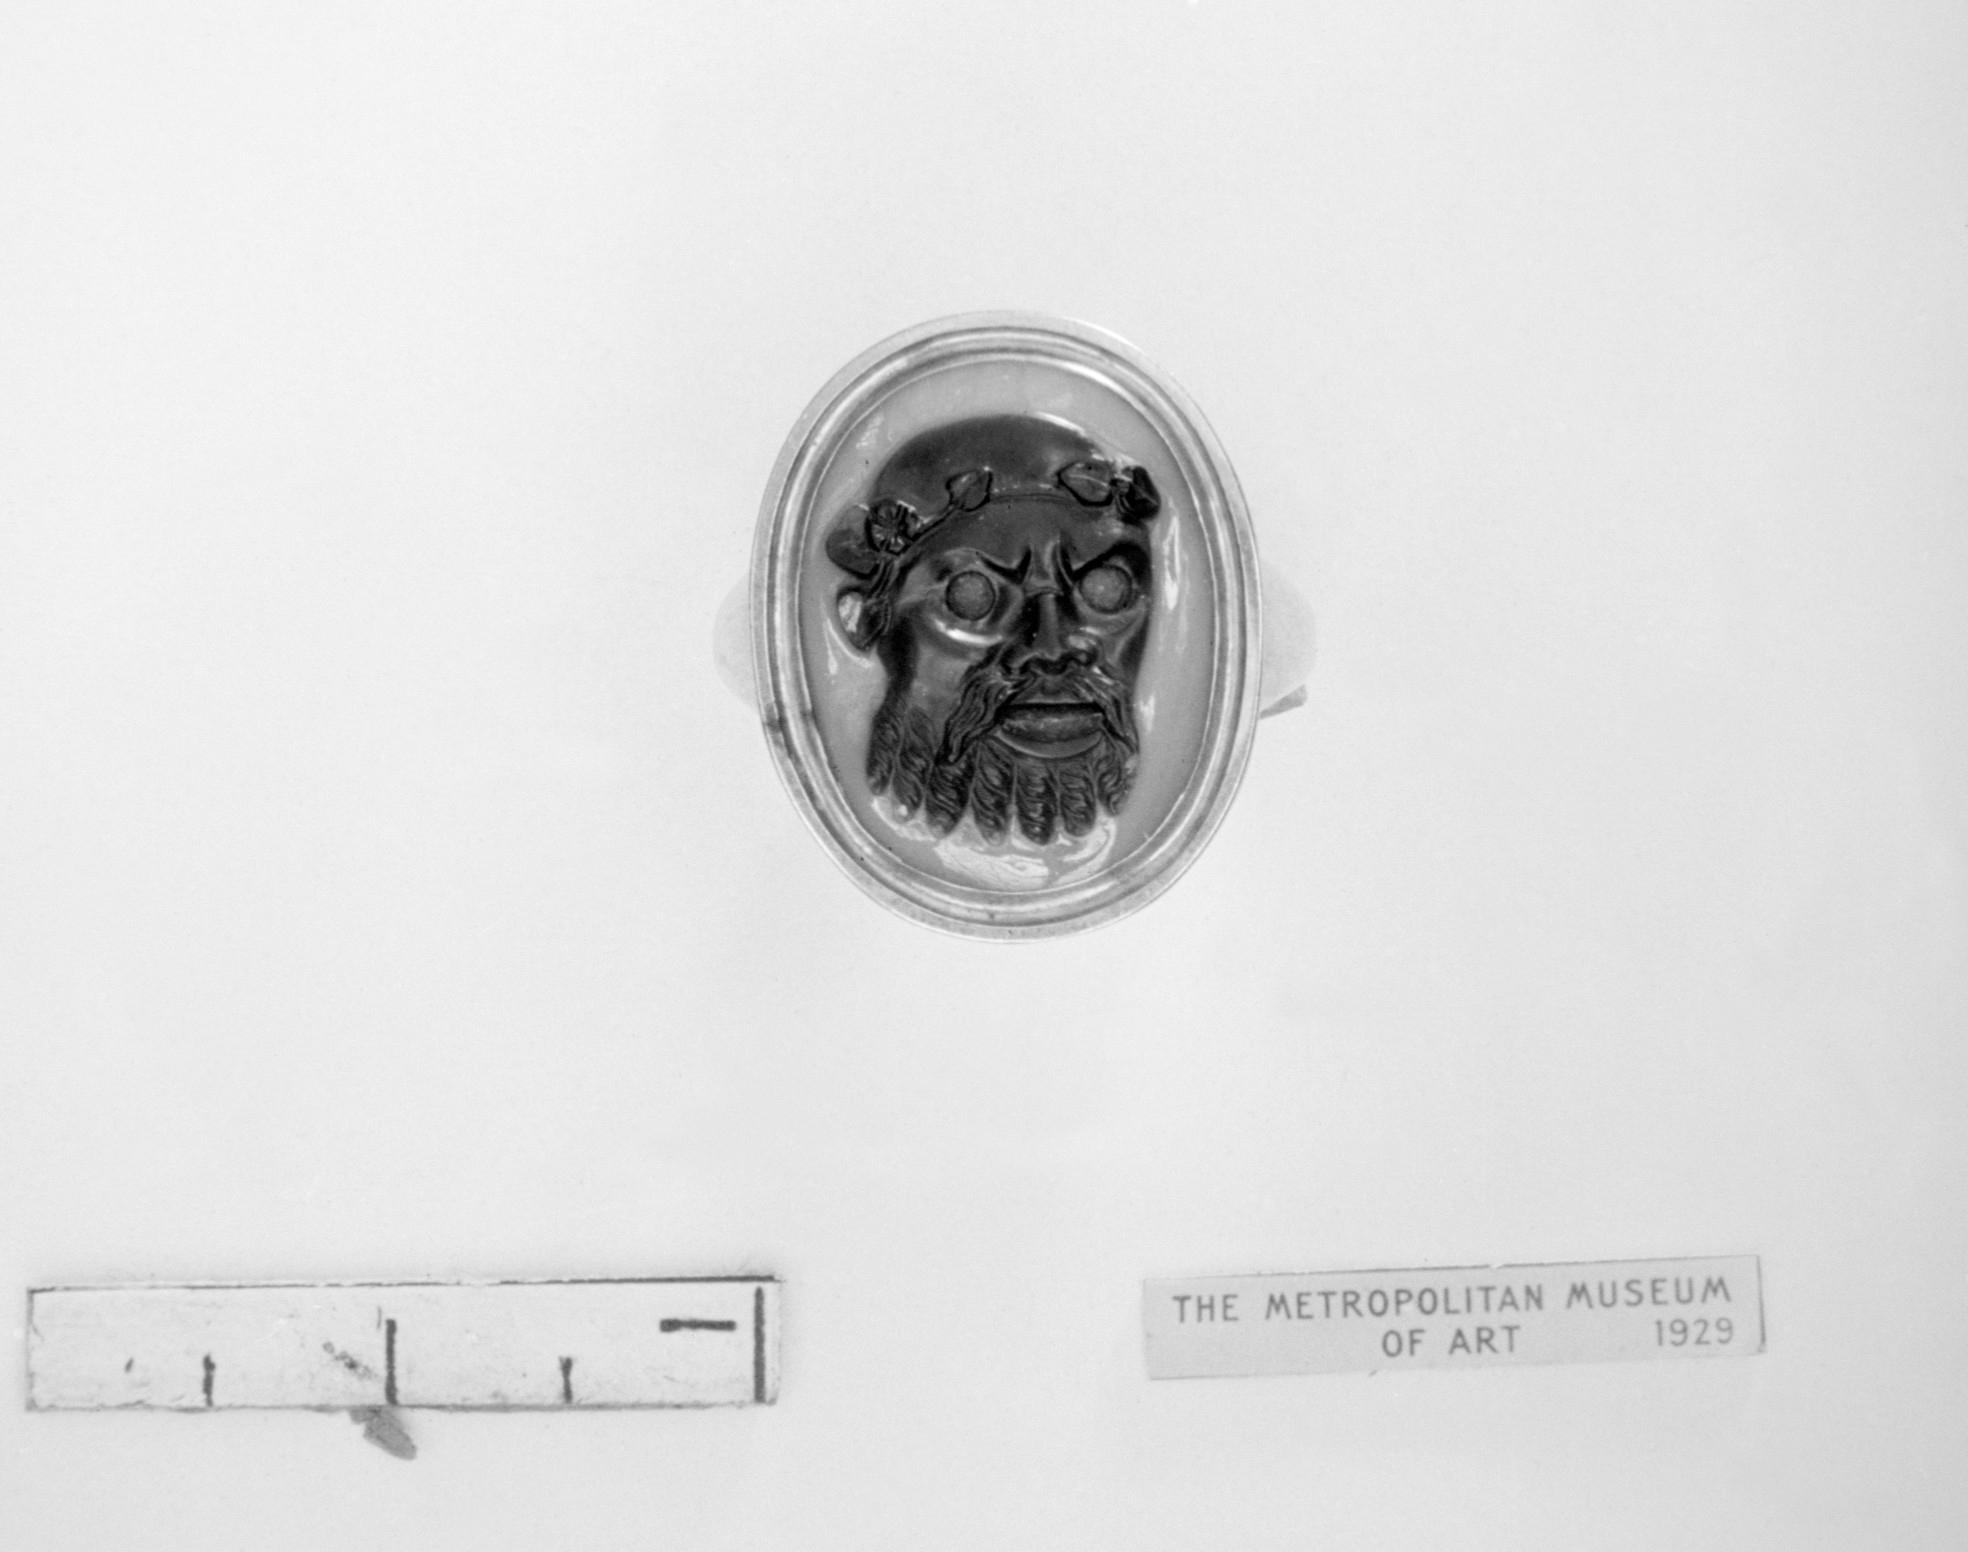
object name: cameo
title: Mask of Silenus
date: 1701-1800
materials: gold, gemstone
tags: masks,silenus